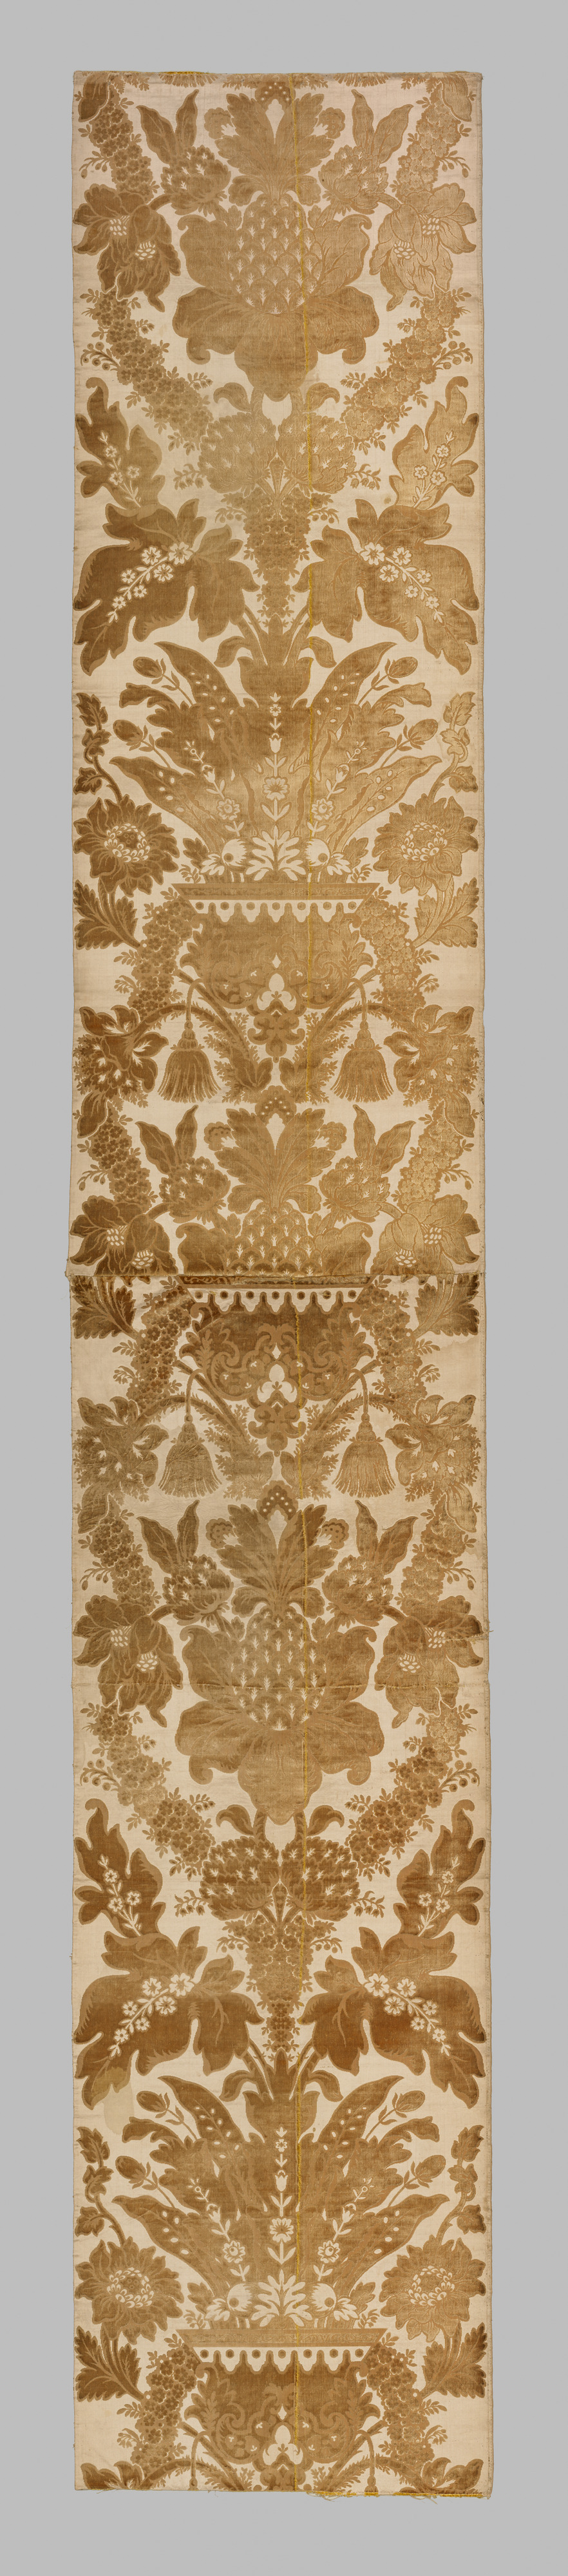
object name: piece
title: Length of furnishing velvet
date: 1701-1725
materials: silk